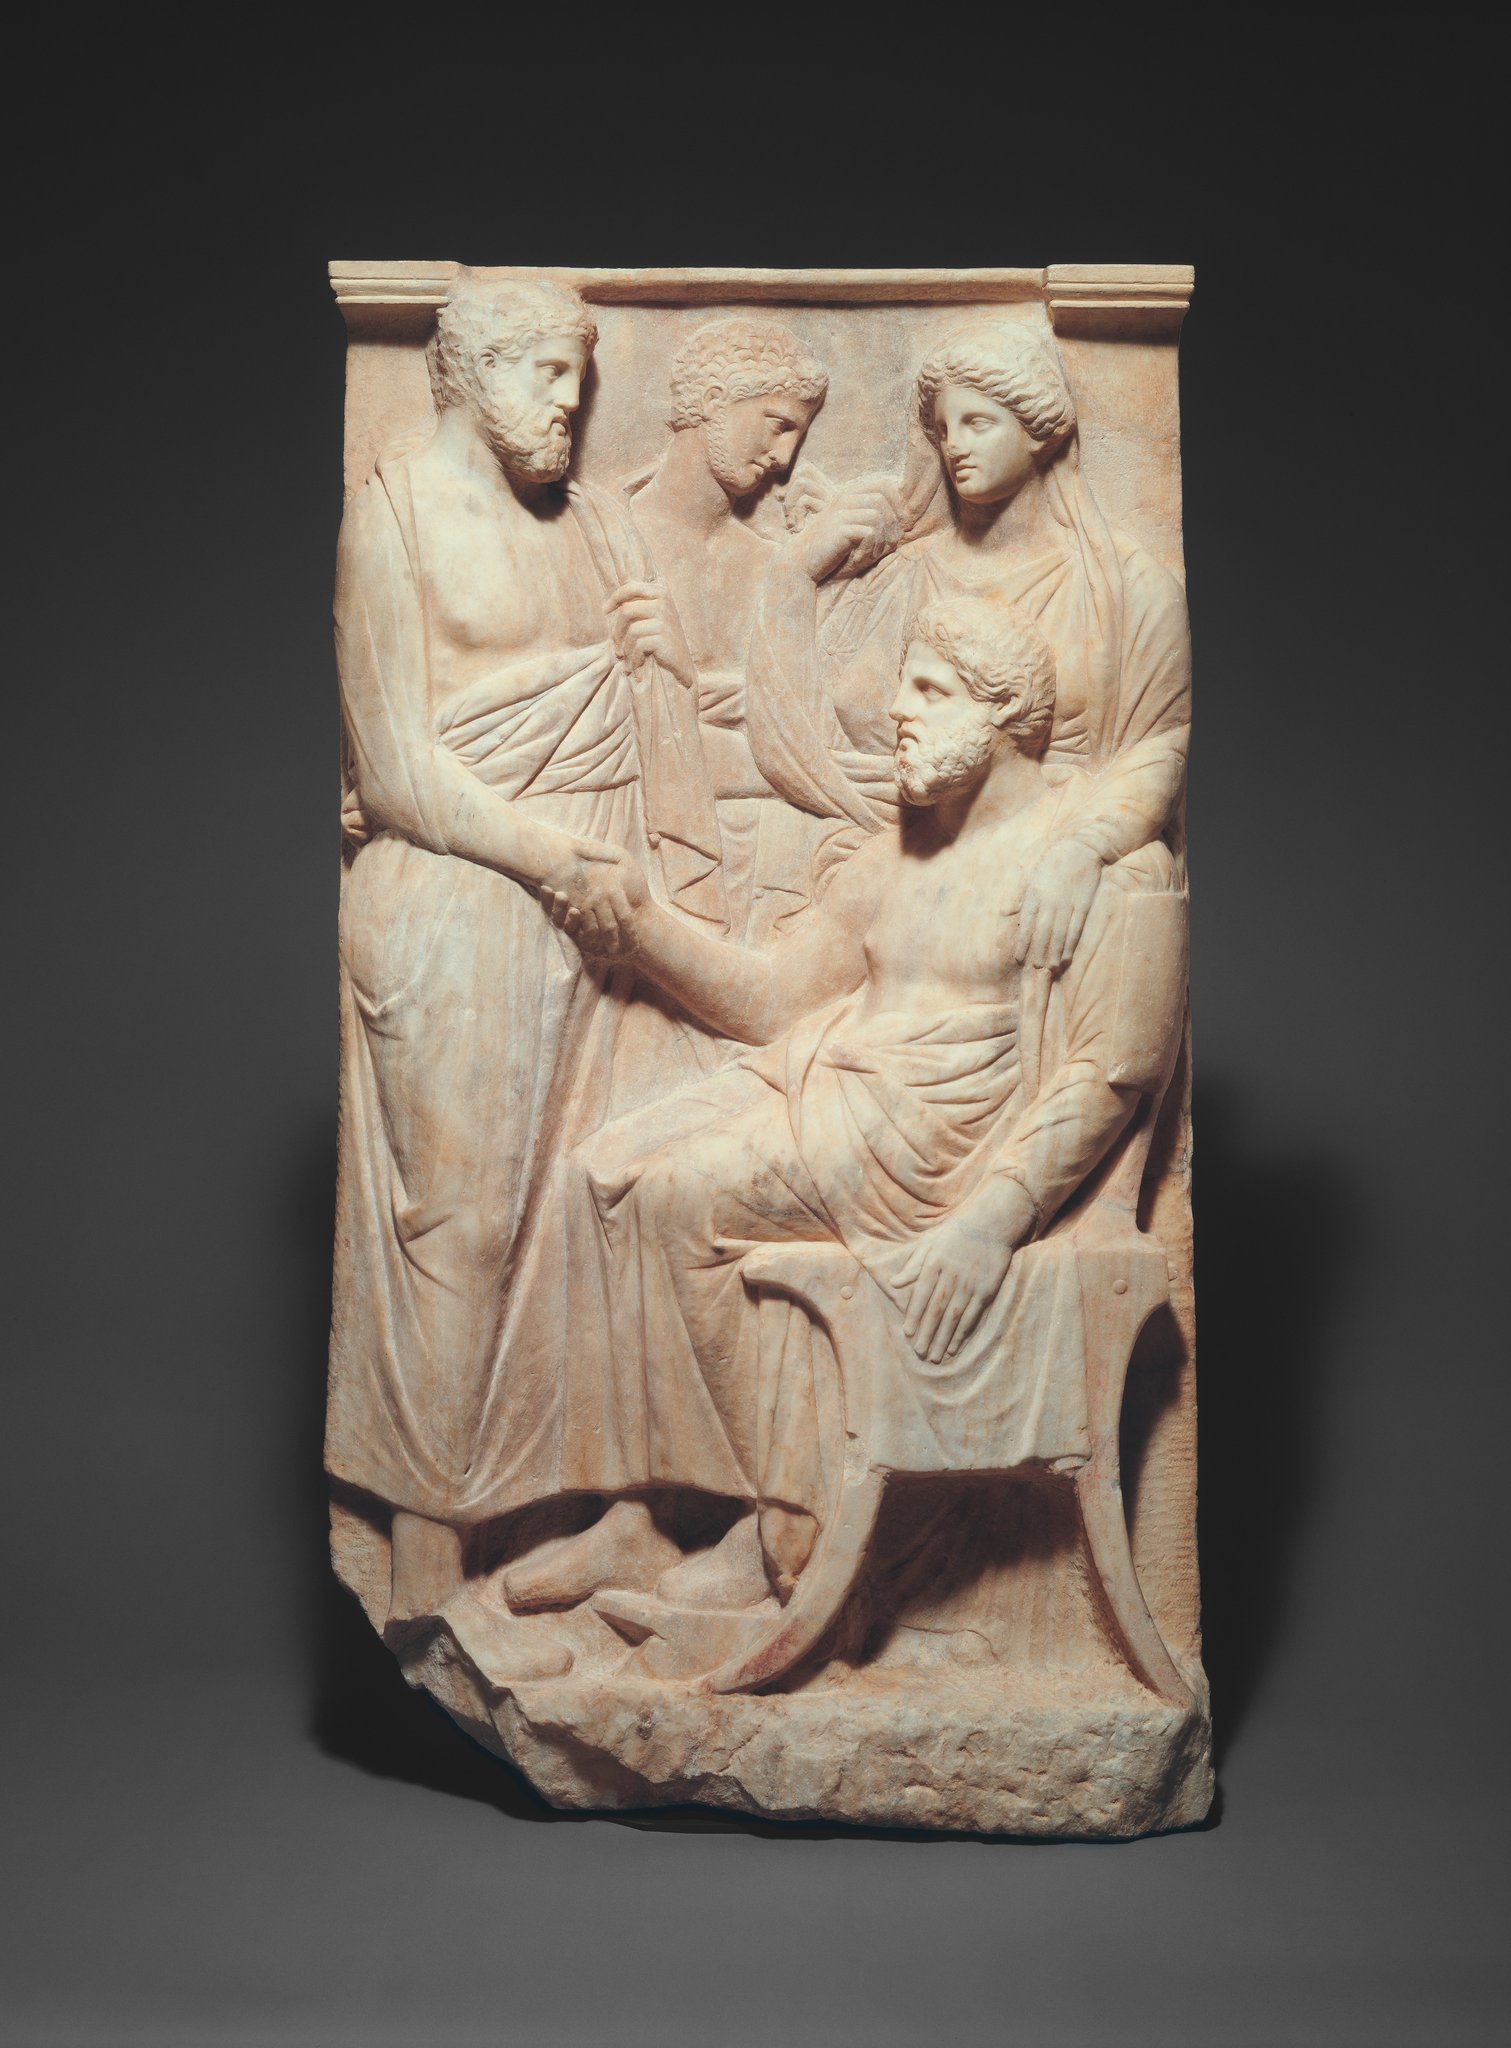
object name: grave stele of a man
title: Marble stele (grave marker) of a man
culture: greek, attic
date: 375-350 BCE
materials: marble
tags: men,women